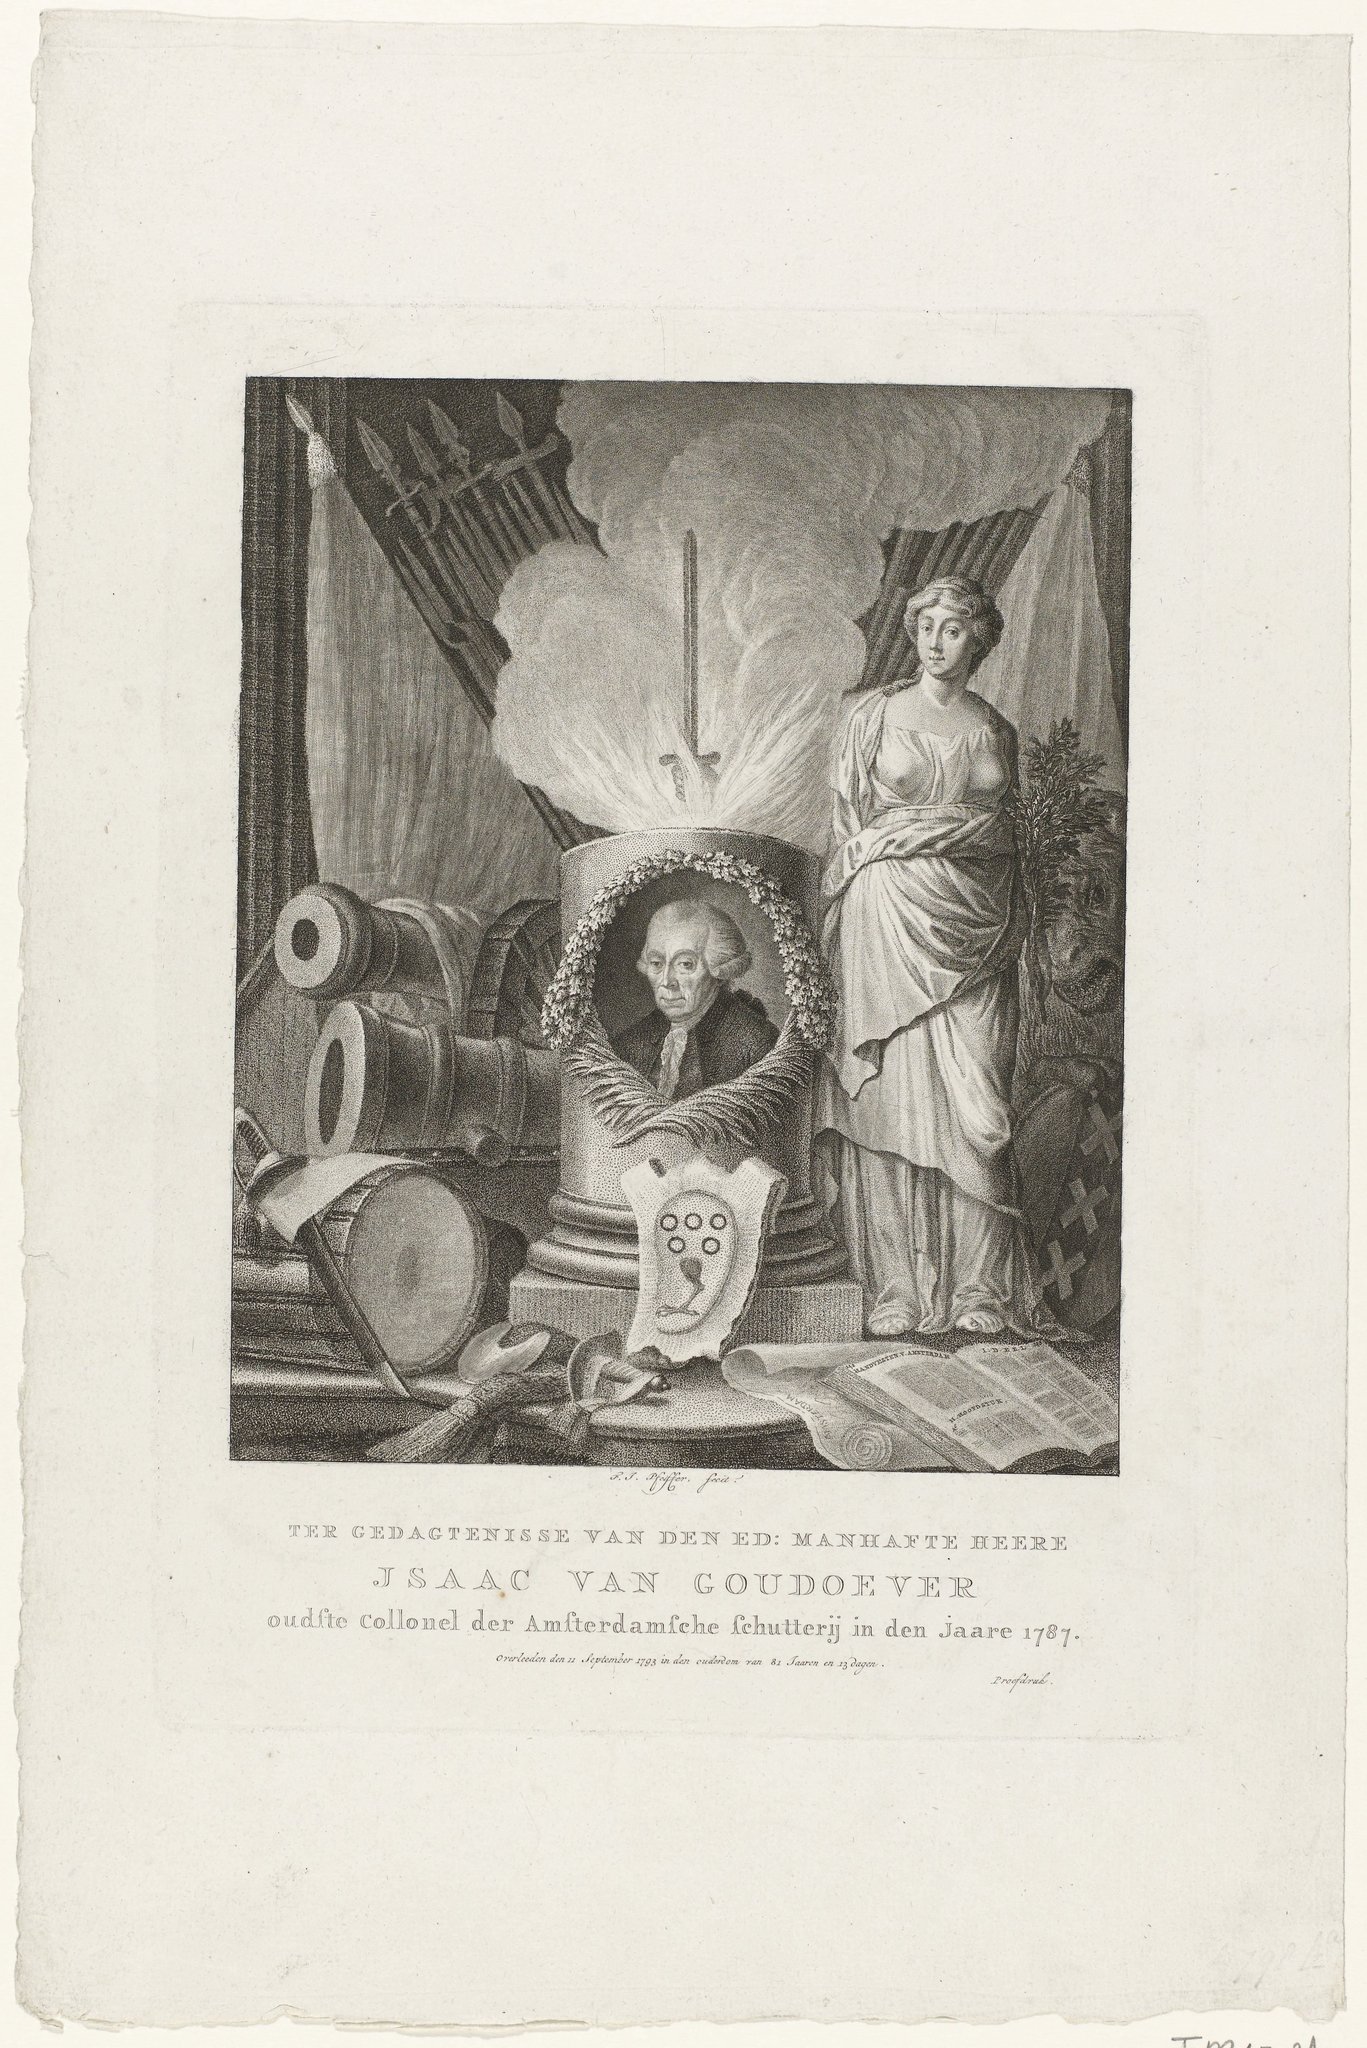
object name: print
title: Allegorisch monument voor Isaac van Goudoever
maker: françois joseph pfeiffer (i)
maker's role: print maker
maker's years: 1741-1807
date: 1793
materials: paper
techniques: stippled etching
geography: northern netherlands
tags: amsterdam, patriots (1780-1795)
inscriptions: collector's mark: Lugt 2228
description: Allegorisch monument voor Isaak van Goedoever, overleden 11 september 1793. Portret van Goudoever in eikenkrans op een afgebroken zuil, rechts een allegorisch vrouwenfiguur, de Vrijheid of de Vrede, die haar hand met zwaard in het vuur houdt. Links kanonnen, trommel, vaandels en wapens. Op de voorgrond het familiewapen en een opengeslagen boek met de handvesten van Amsterdam.